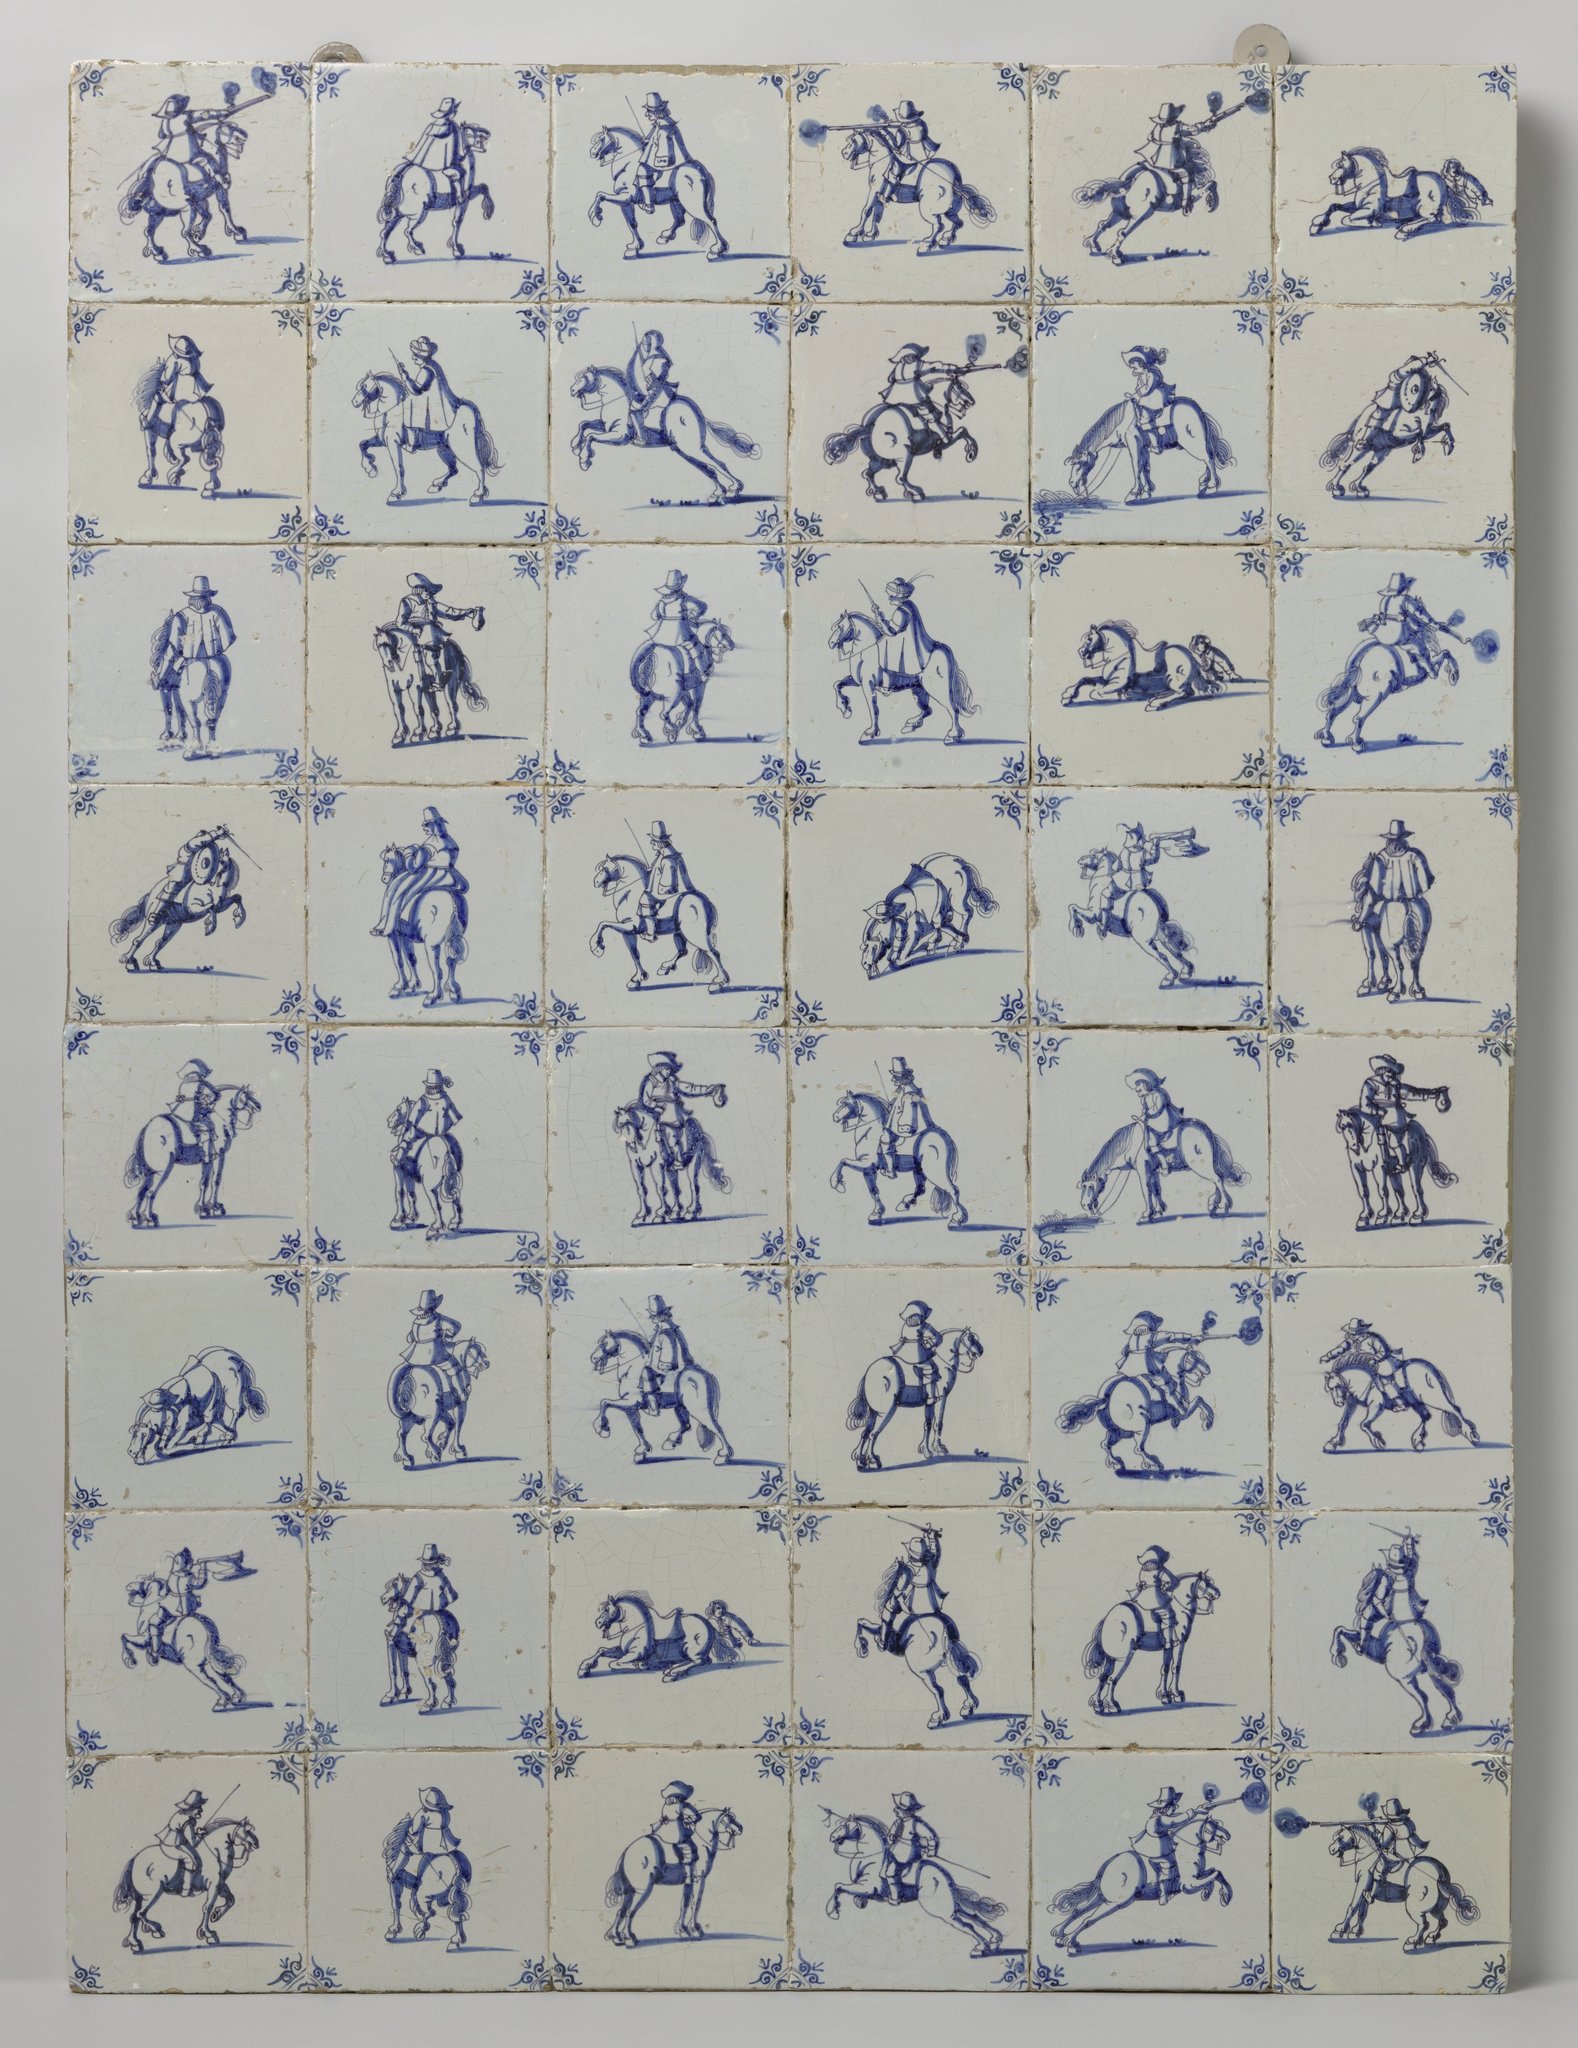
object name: ruitertegel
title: Veld van achtenveertig tegels met ruiters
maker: Anonymous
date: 1675-1725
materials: earthenware, glaze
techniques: maiolica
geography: netherlands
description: Veld van achtenveertig tegels (8 x 6) elk met een blauw en paars geschilderde ruiter met in de hoeken, een ossekop.